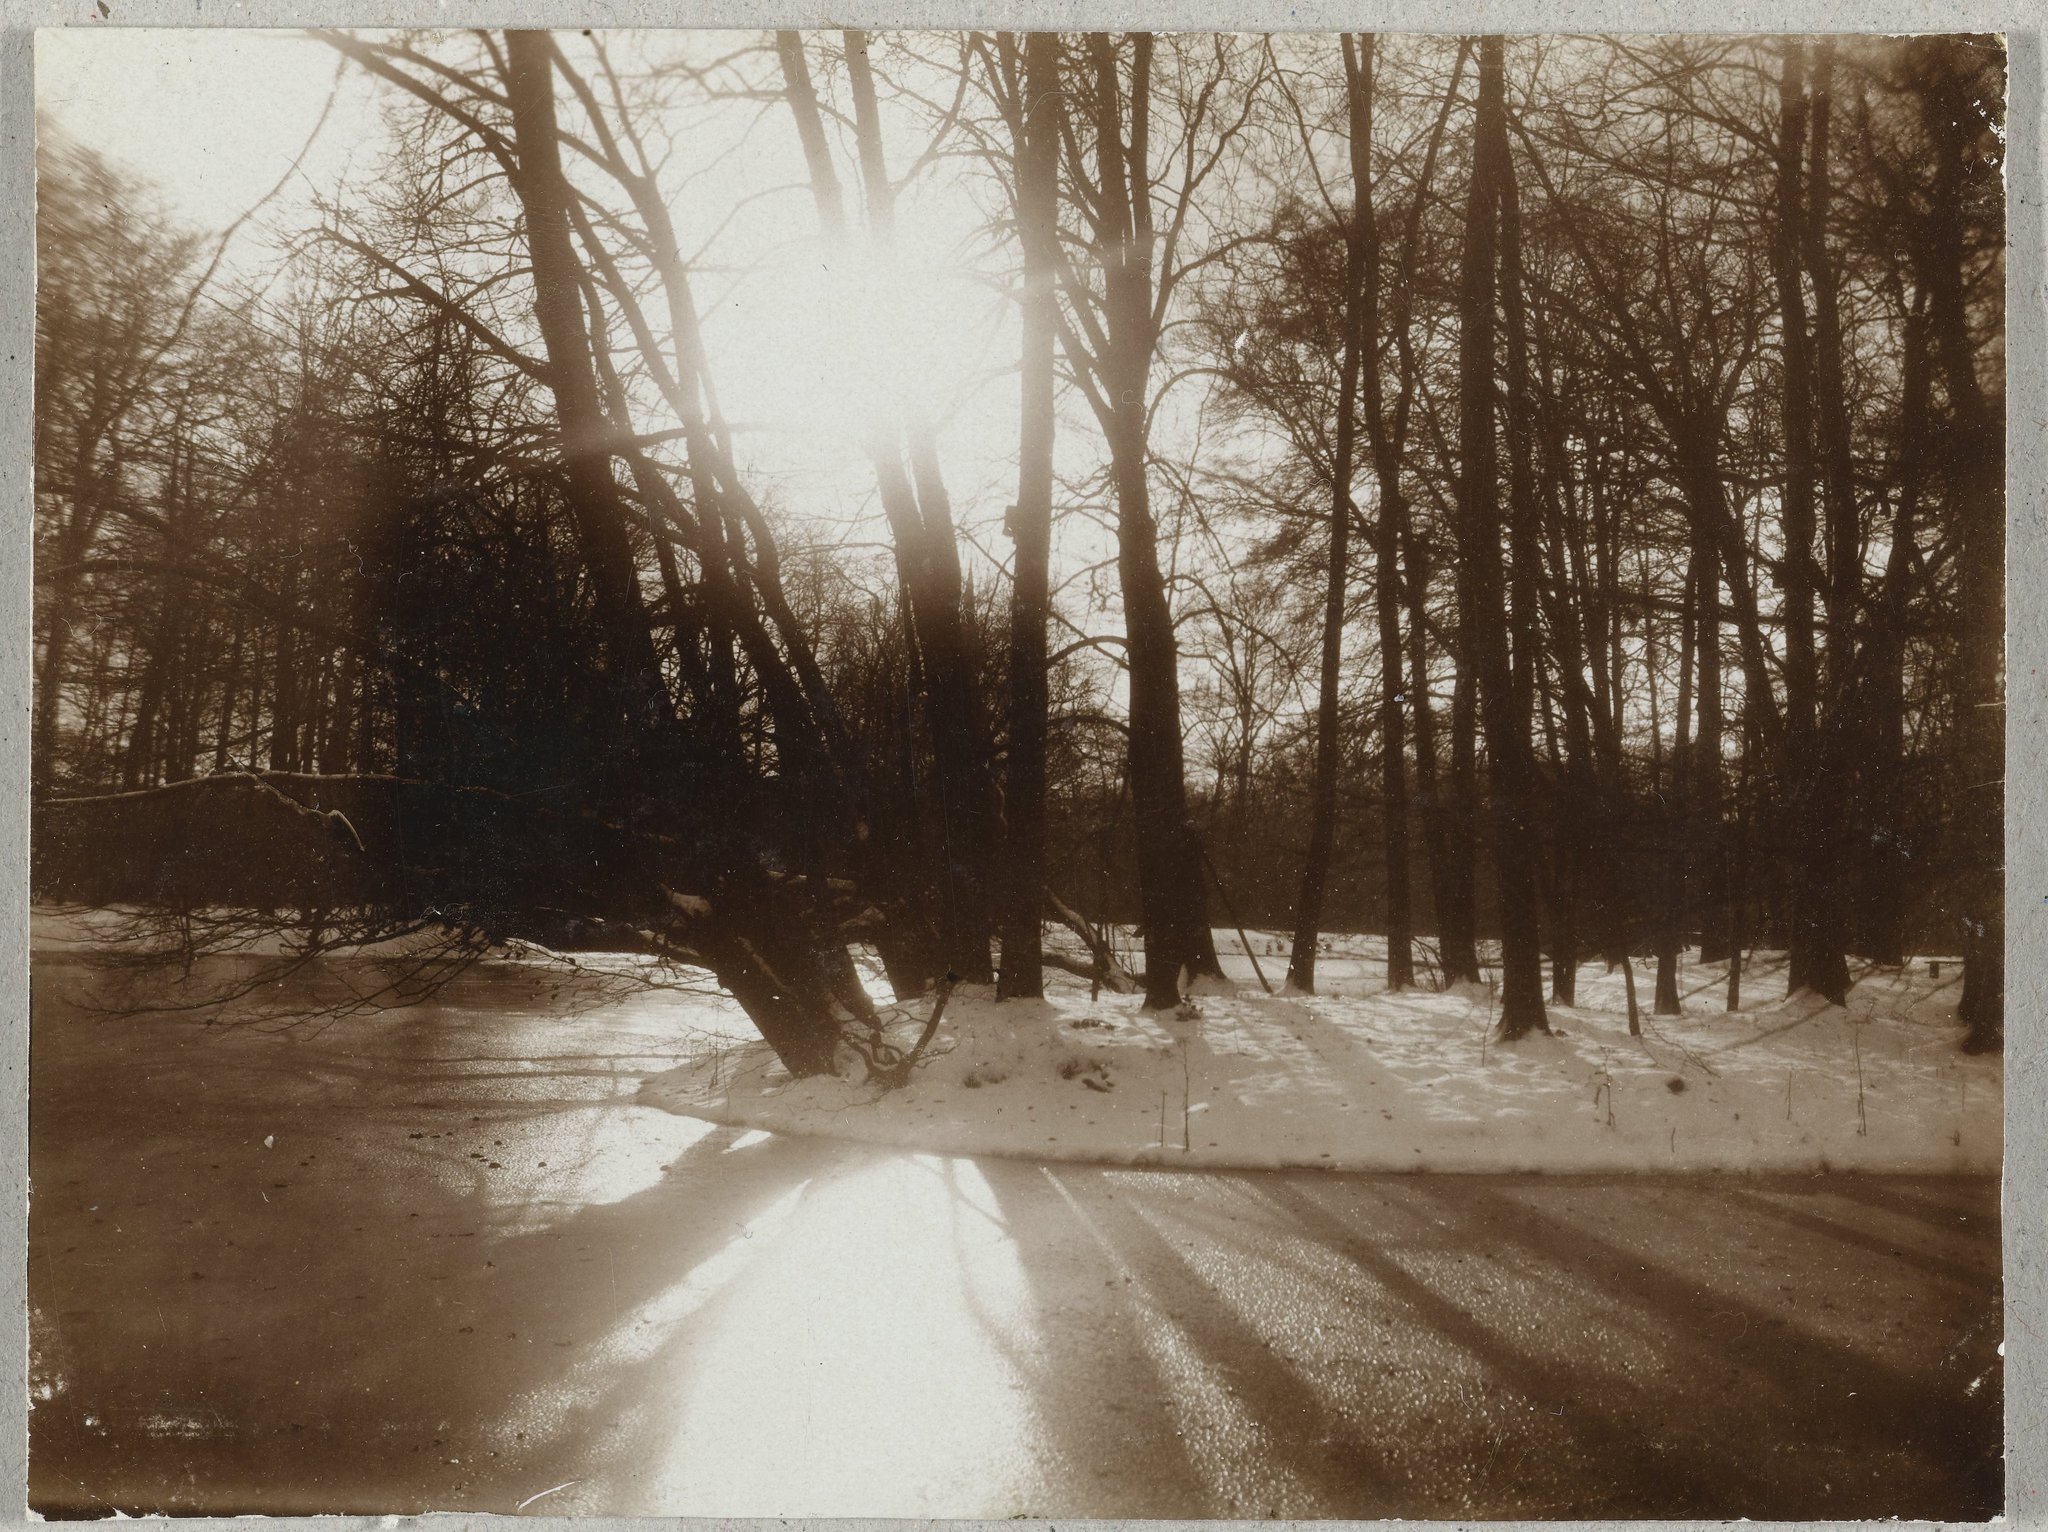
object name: photograph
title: Gezicht in het Haagse Bos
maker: Anonymous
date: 1923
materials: photographic support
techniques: collodion silver print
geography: netherlands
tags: forest, wood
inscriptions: annotation: ‘Haagse bos’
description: Gekocht als serie van 6 foto's (RP-F-2005-40 t/m 45) die verkocht werden als 'Haagse Bos, 1923'